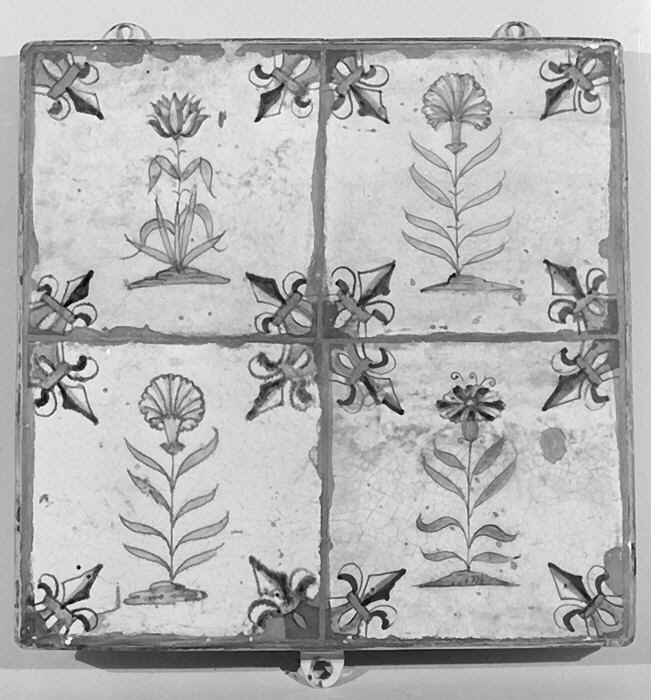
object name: tile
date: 1640-1660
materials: earthenware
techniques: glazing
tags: flowers